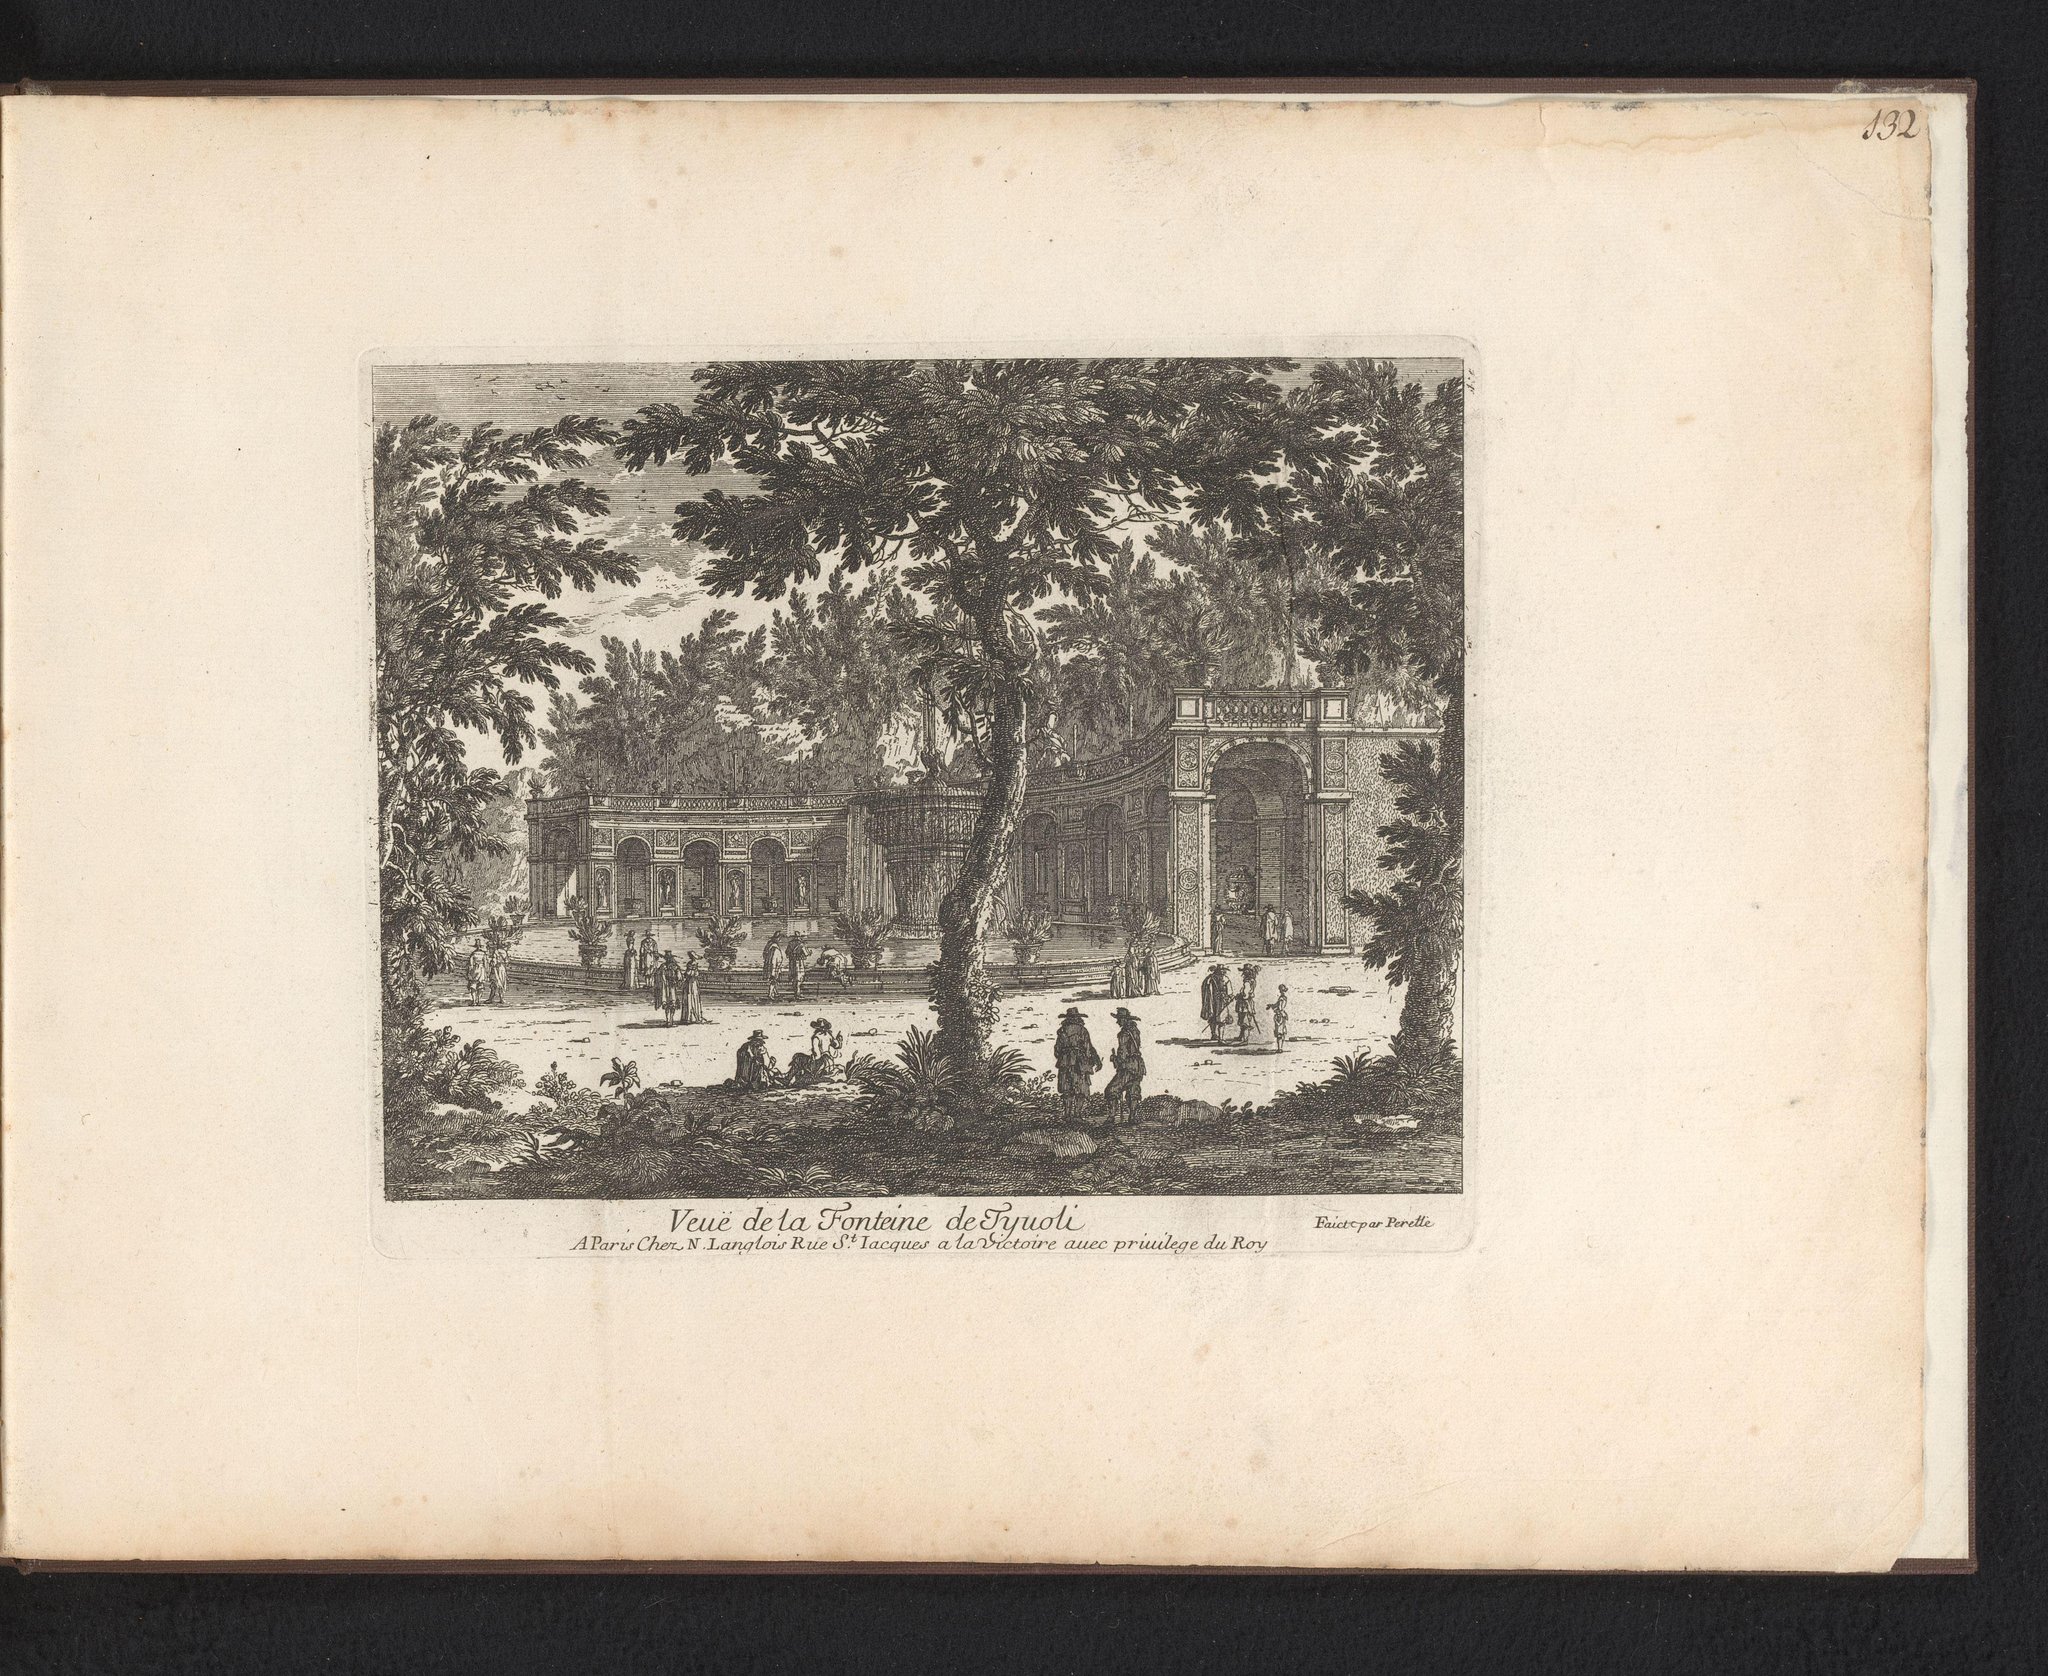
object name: album leaf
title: Gezicht op een fontein bij Villa d'Este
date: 1650-1695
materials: paper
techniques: etching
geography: france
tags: garden fountain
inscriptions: collector's mark: Lugt 2228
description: Prenten met het signatuur 'Perelle' kunnen zowel door vader Gabriel als door zonen Nicolas en Adam gemaakt zijn. De uitgevers vader en zoon Nicolas Langlois worden allebei vermeld als N. Langlois op hetzelfde adres.